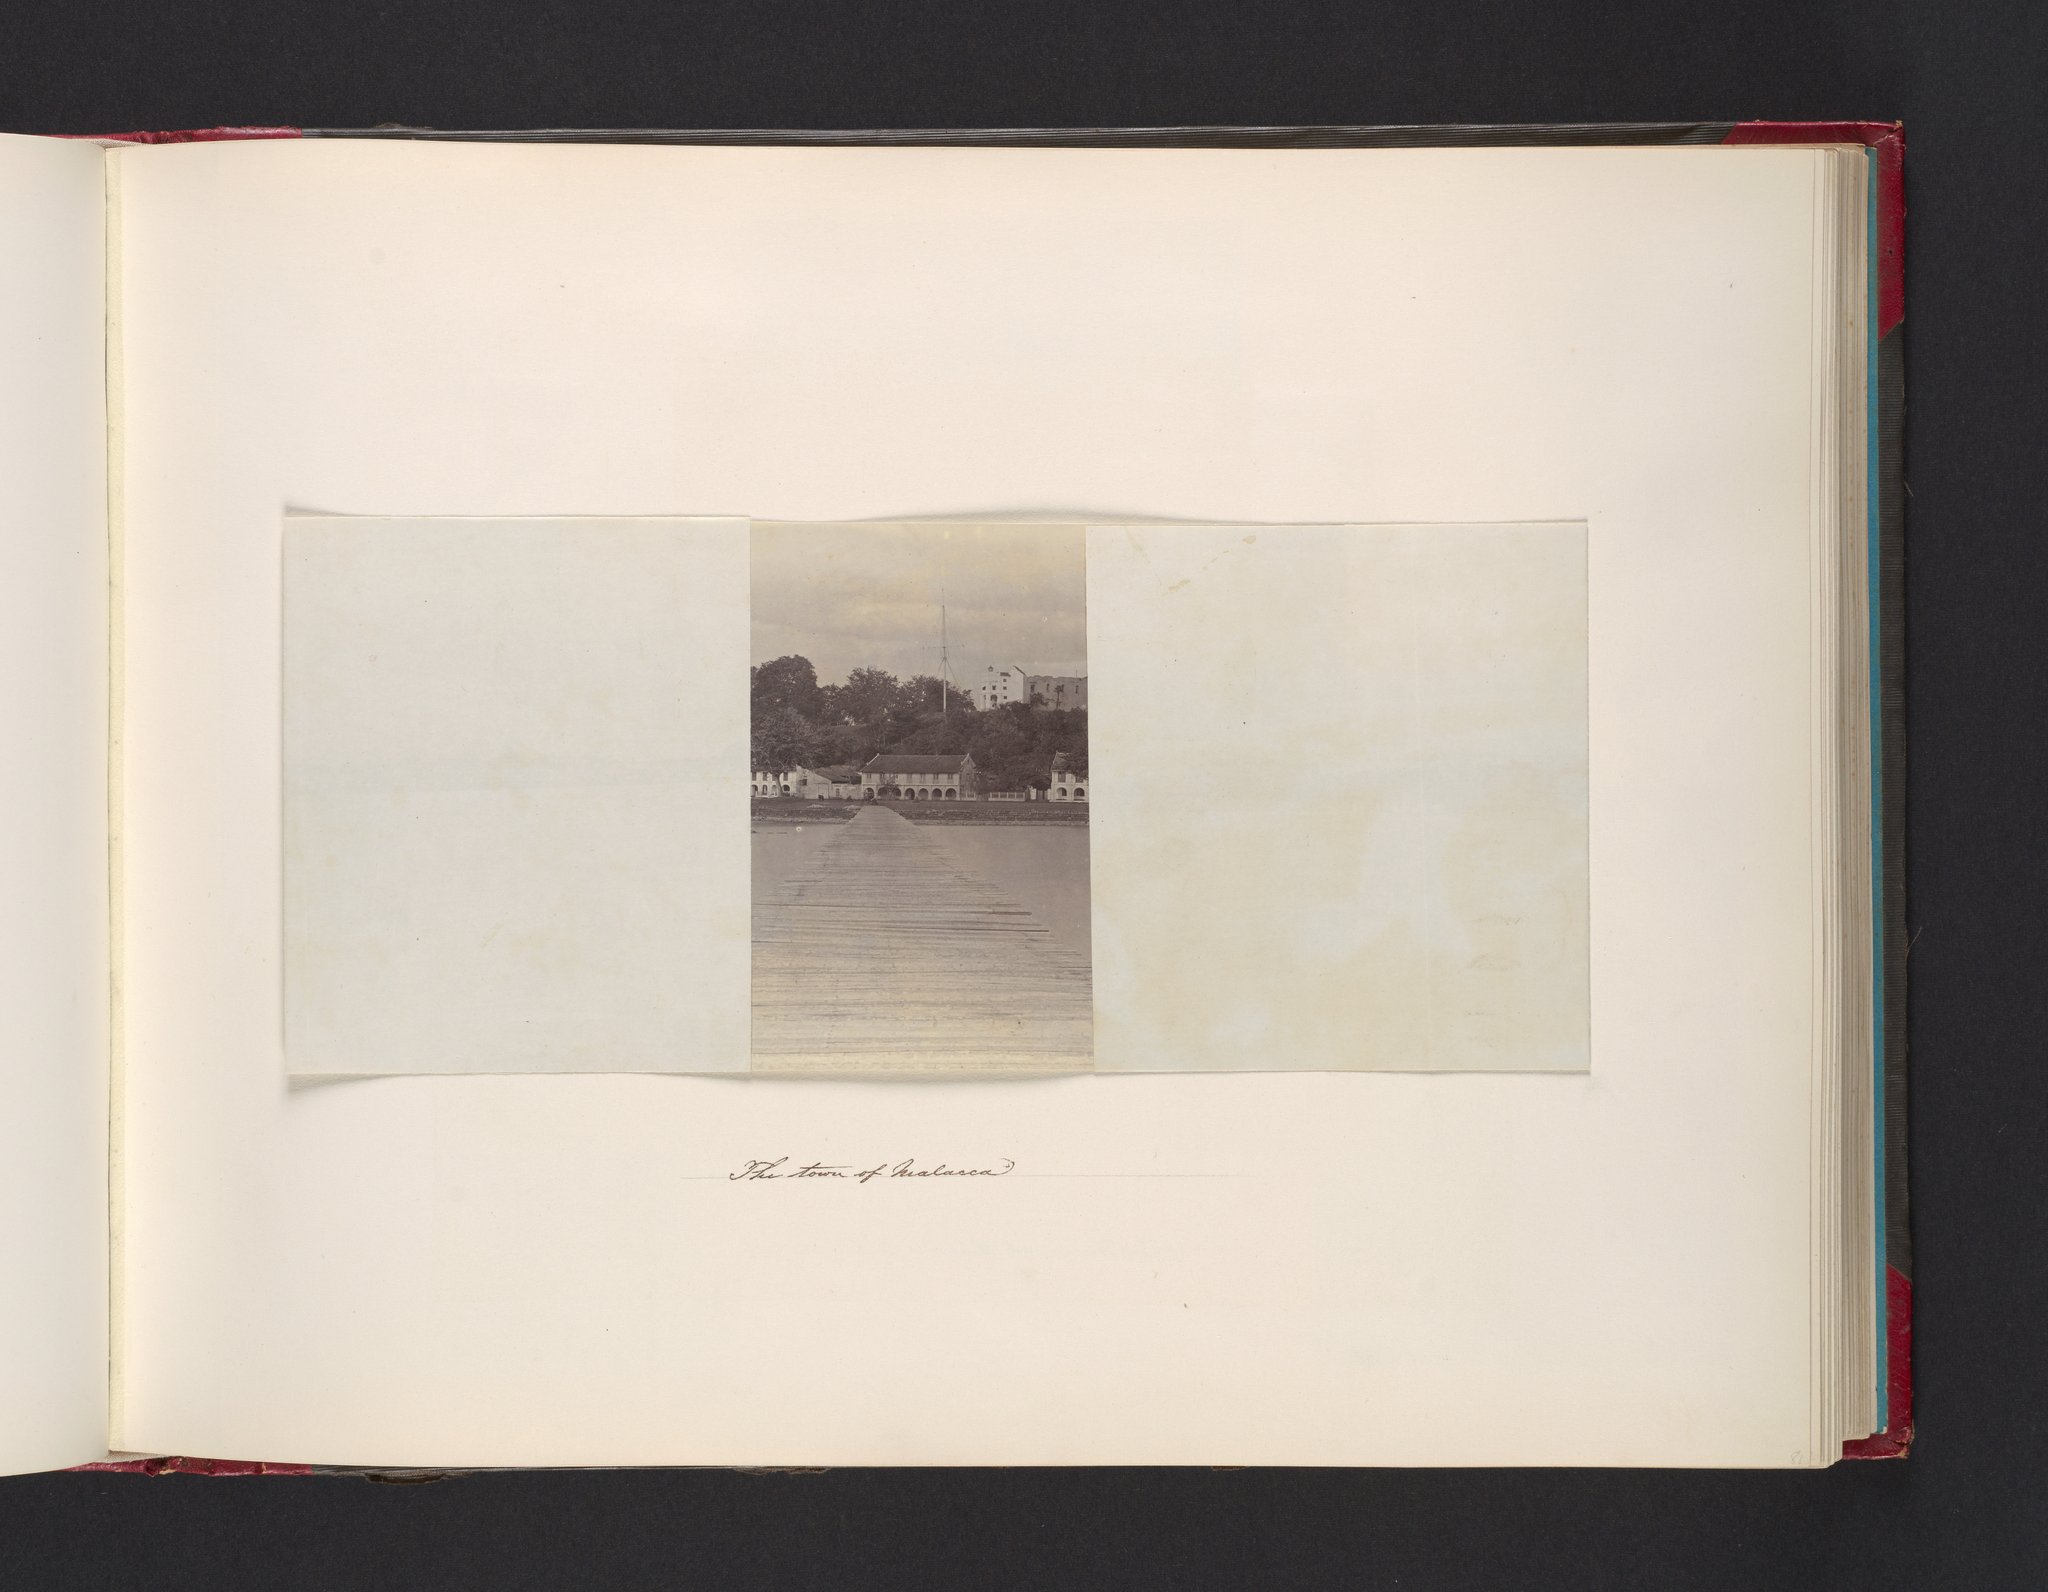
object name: photograph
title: The Town of Malacca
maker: john thomson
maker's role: artist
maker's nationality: british, scottish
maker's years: 1837-1921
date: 1865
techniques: albumen silver print, glass negative